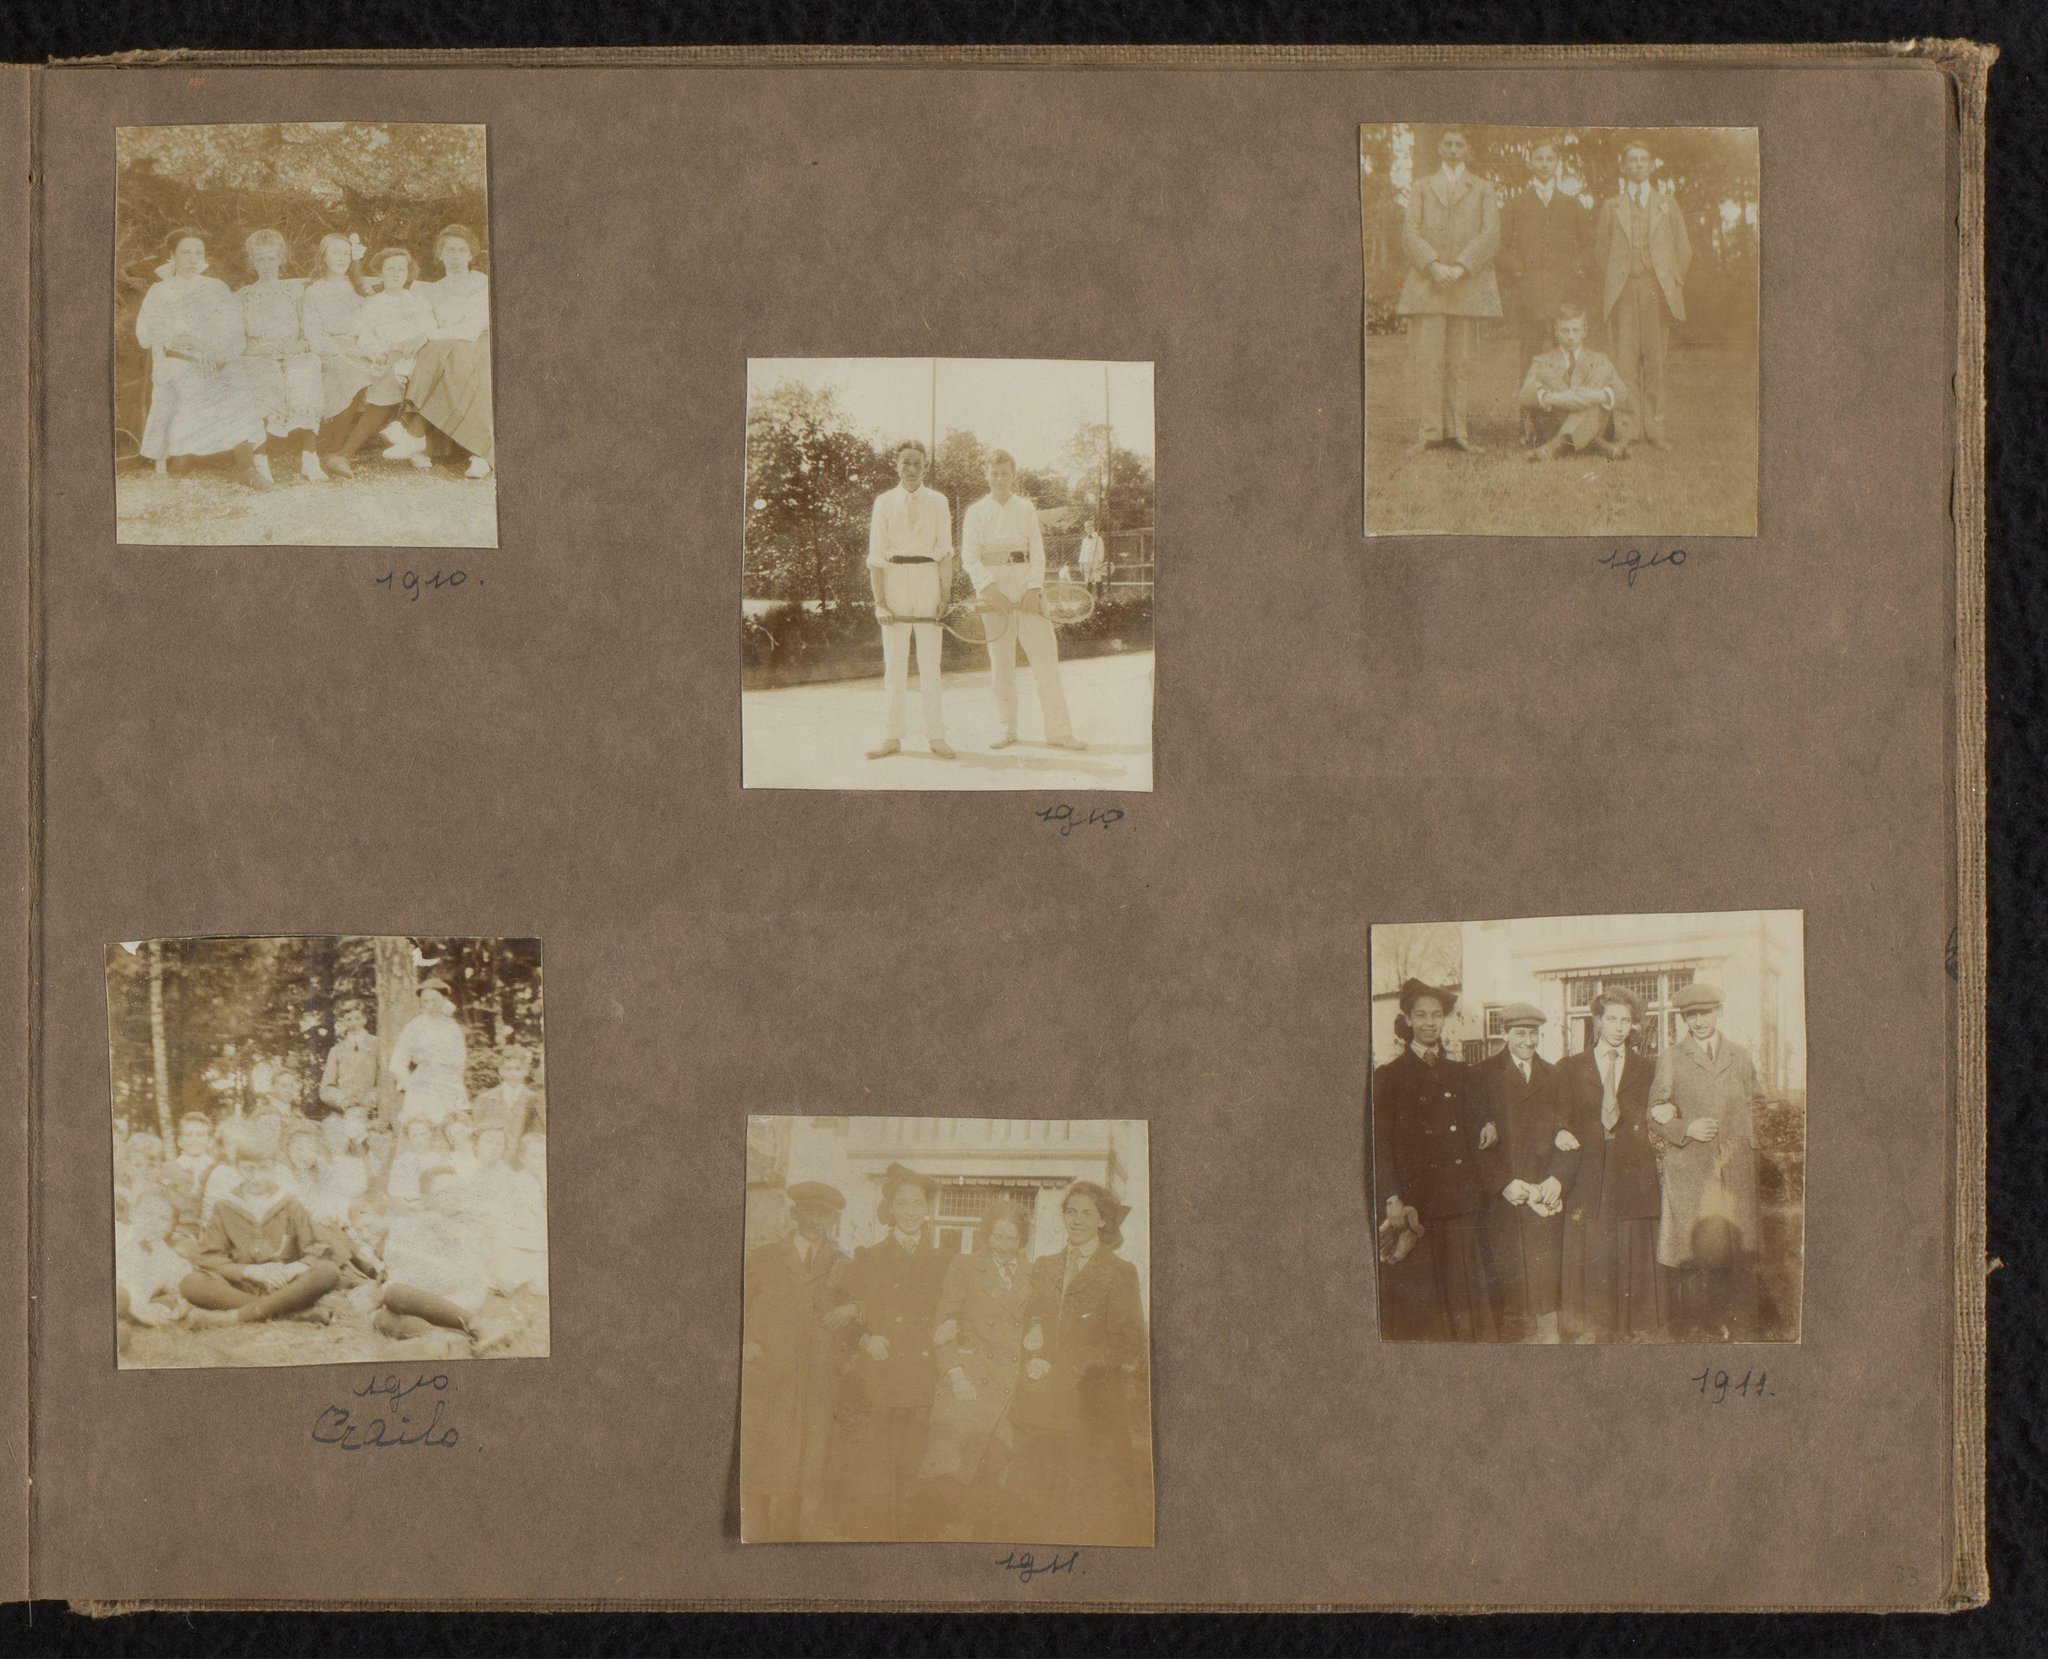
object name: photograph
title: Zes foto's van vrienden van Loentje Onnen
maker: carolina frederika onnen (lien/loen)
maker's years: 1896-1983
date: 1910-1911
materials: paper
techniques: gelatin silver print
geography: netherlands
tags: friends, anonymous historical persons portrayed in a group, in a group-portrait, netherlands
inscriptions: inscription: ‘1910/ Crails’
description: Deze foto's maken deel uit van een album.